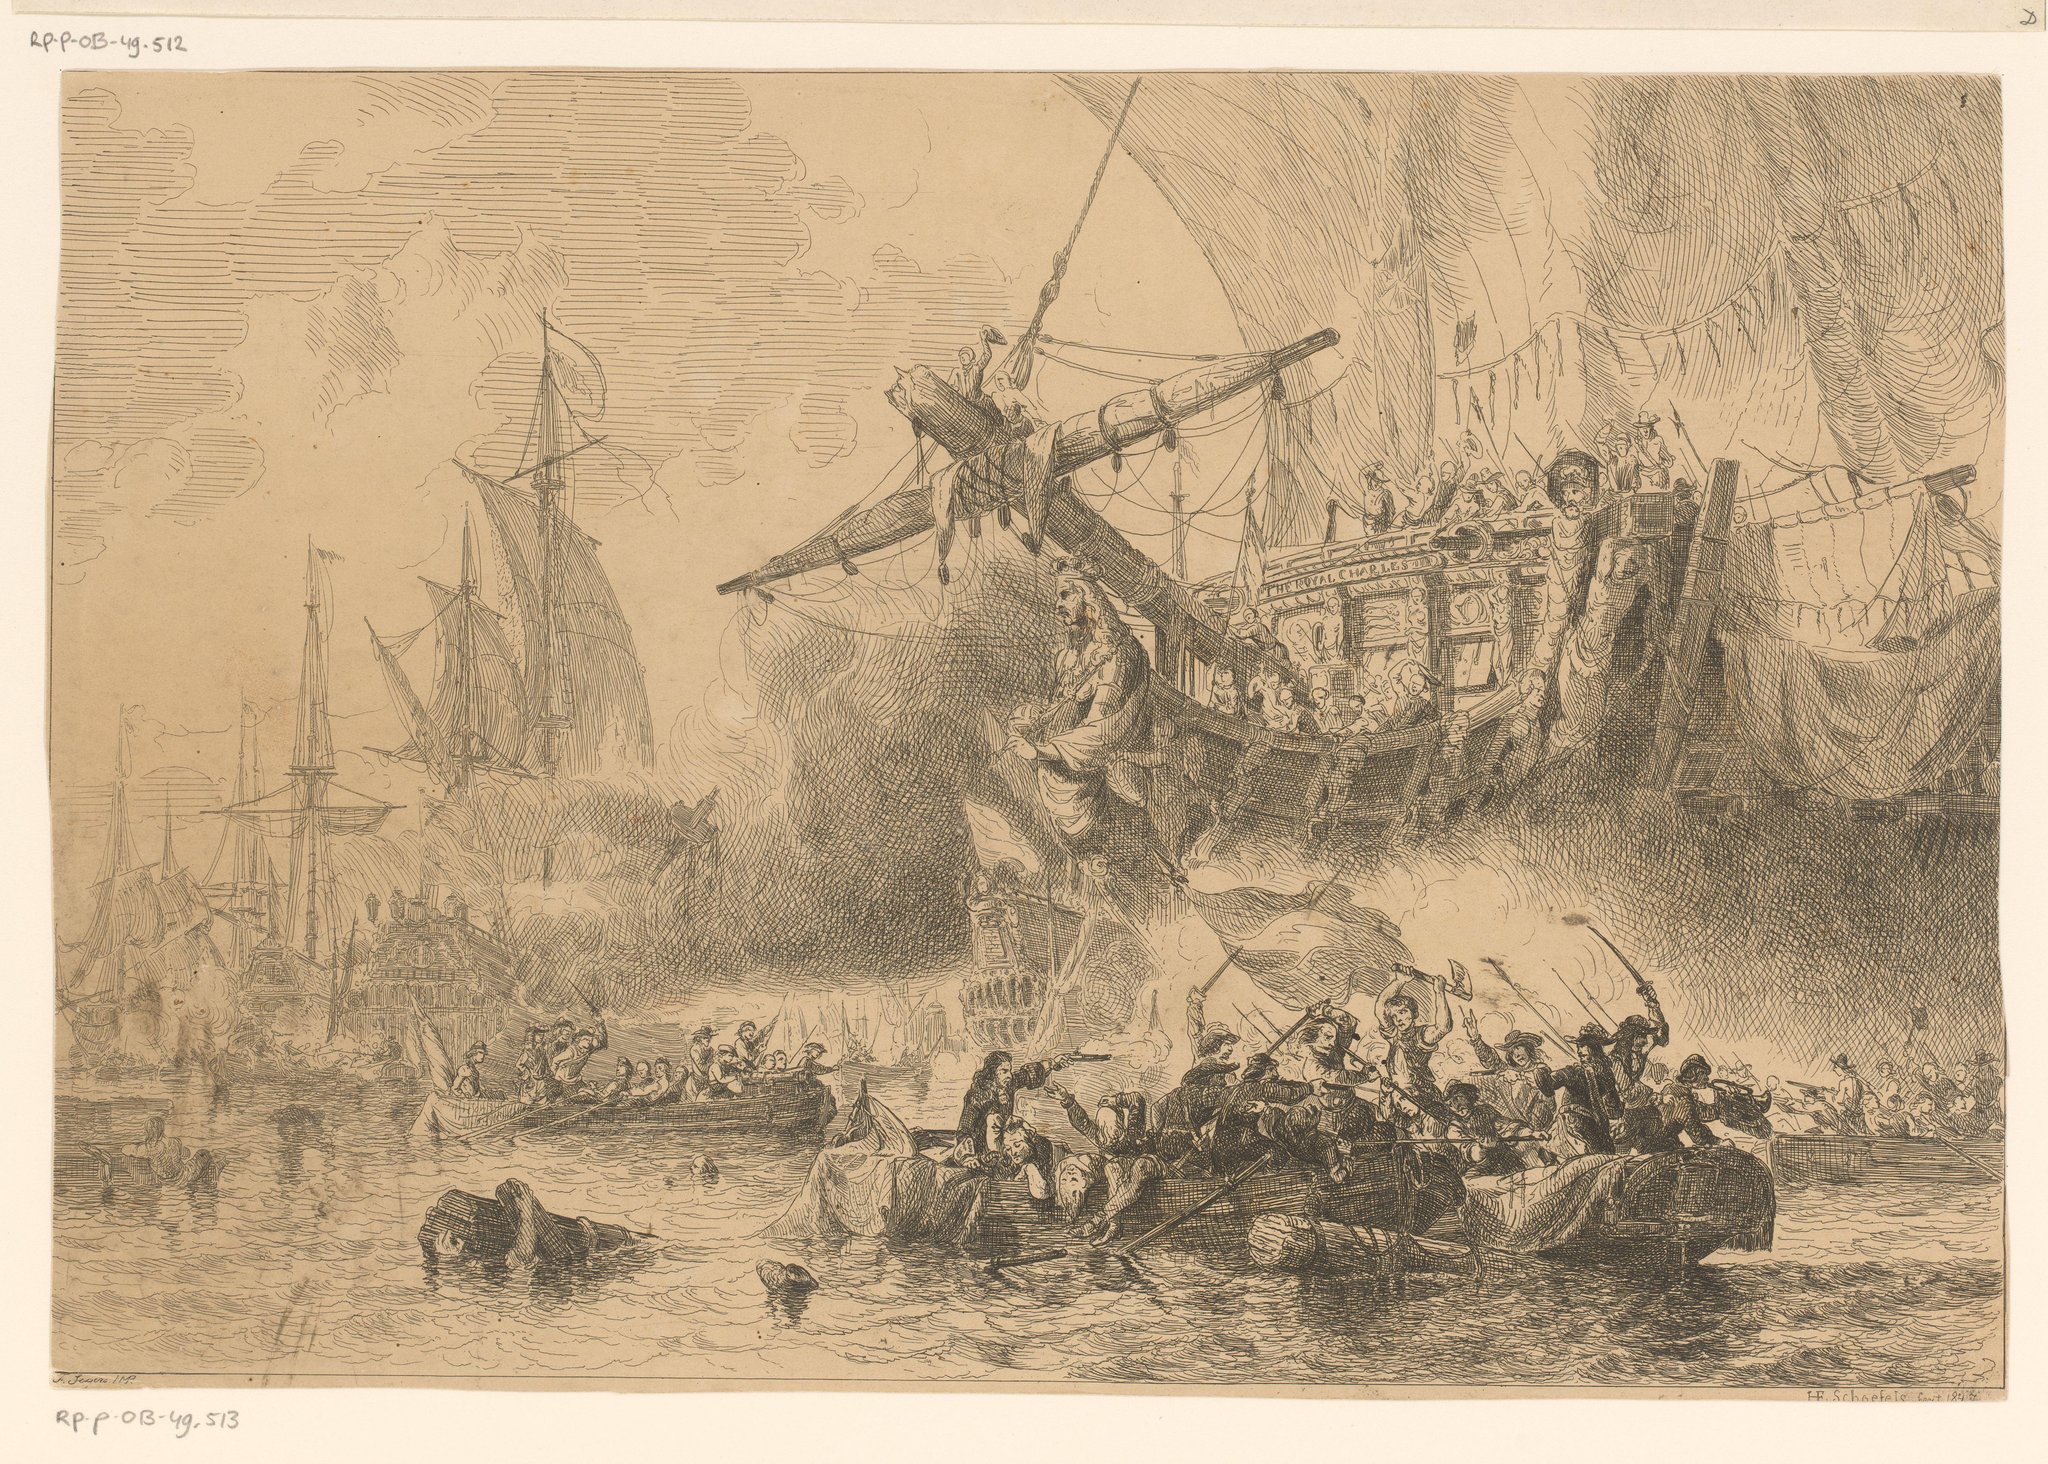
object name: print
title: Het veroveren van de Royal Charles, 1667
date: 1847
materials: paper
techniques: etching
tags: michiel adriaenszoon de ruyter, battle (+ naval force), raid on the medway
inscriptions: collector's mark: Lugt 2228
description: De vernietiging van de Engelse vloot bij Chatham door de Staatse vloot onder admiraal Michiel Adriaenszoon de Ruyter, rechts de verovering van het Engelse vlaggenschip de Royal Charles op 22 juni 1667. Op de voorgrond woeste man-tot-man-gevechten in sloepen.